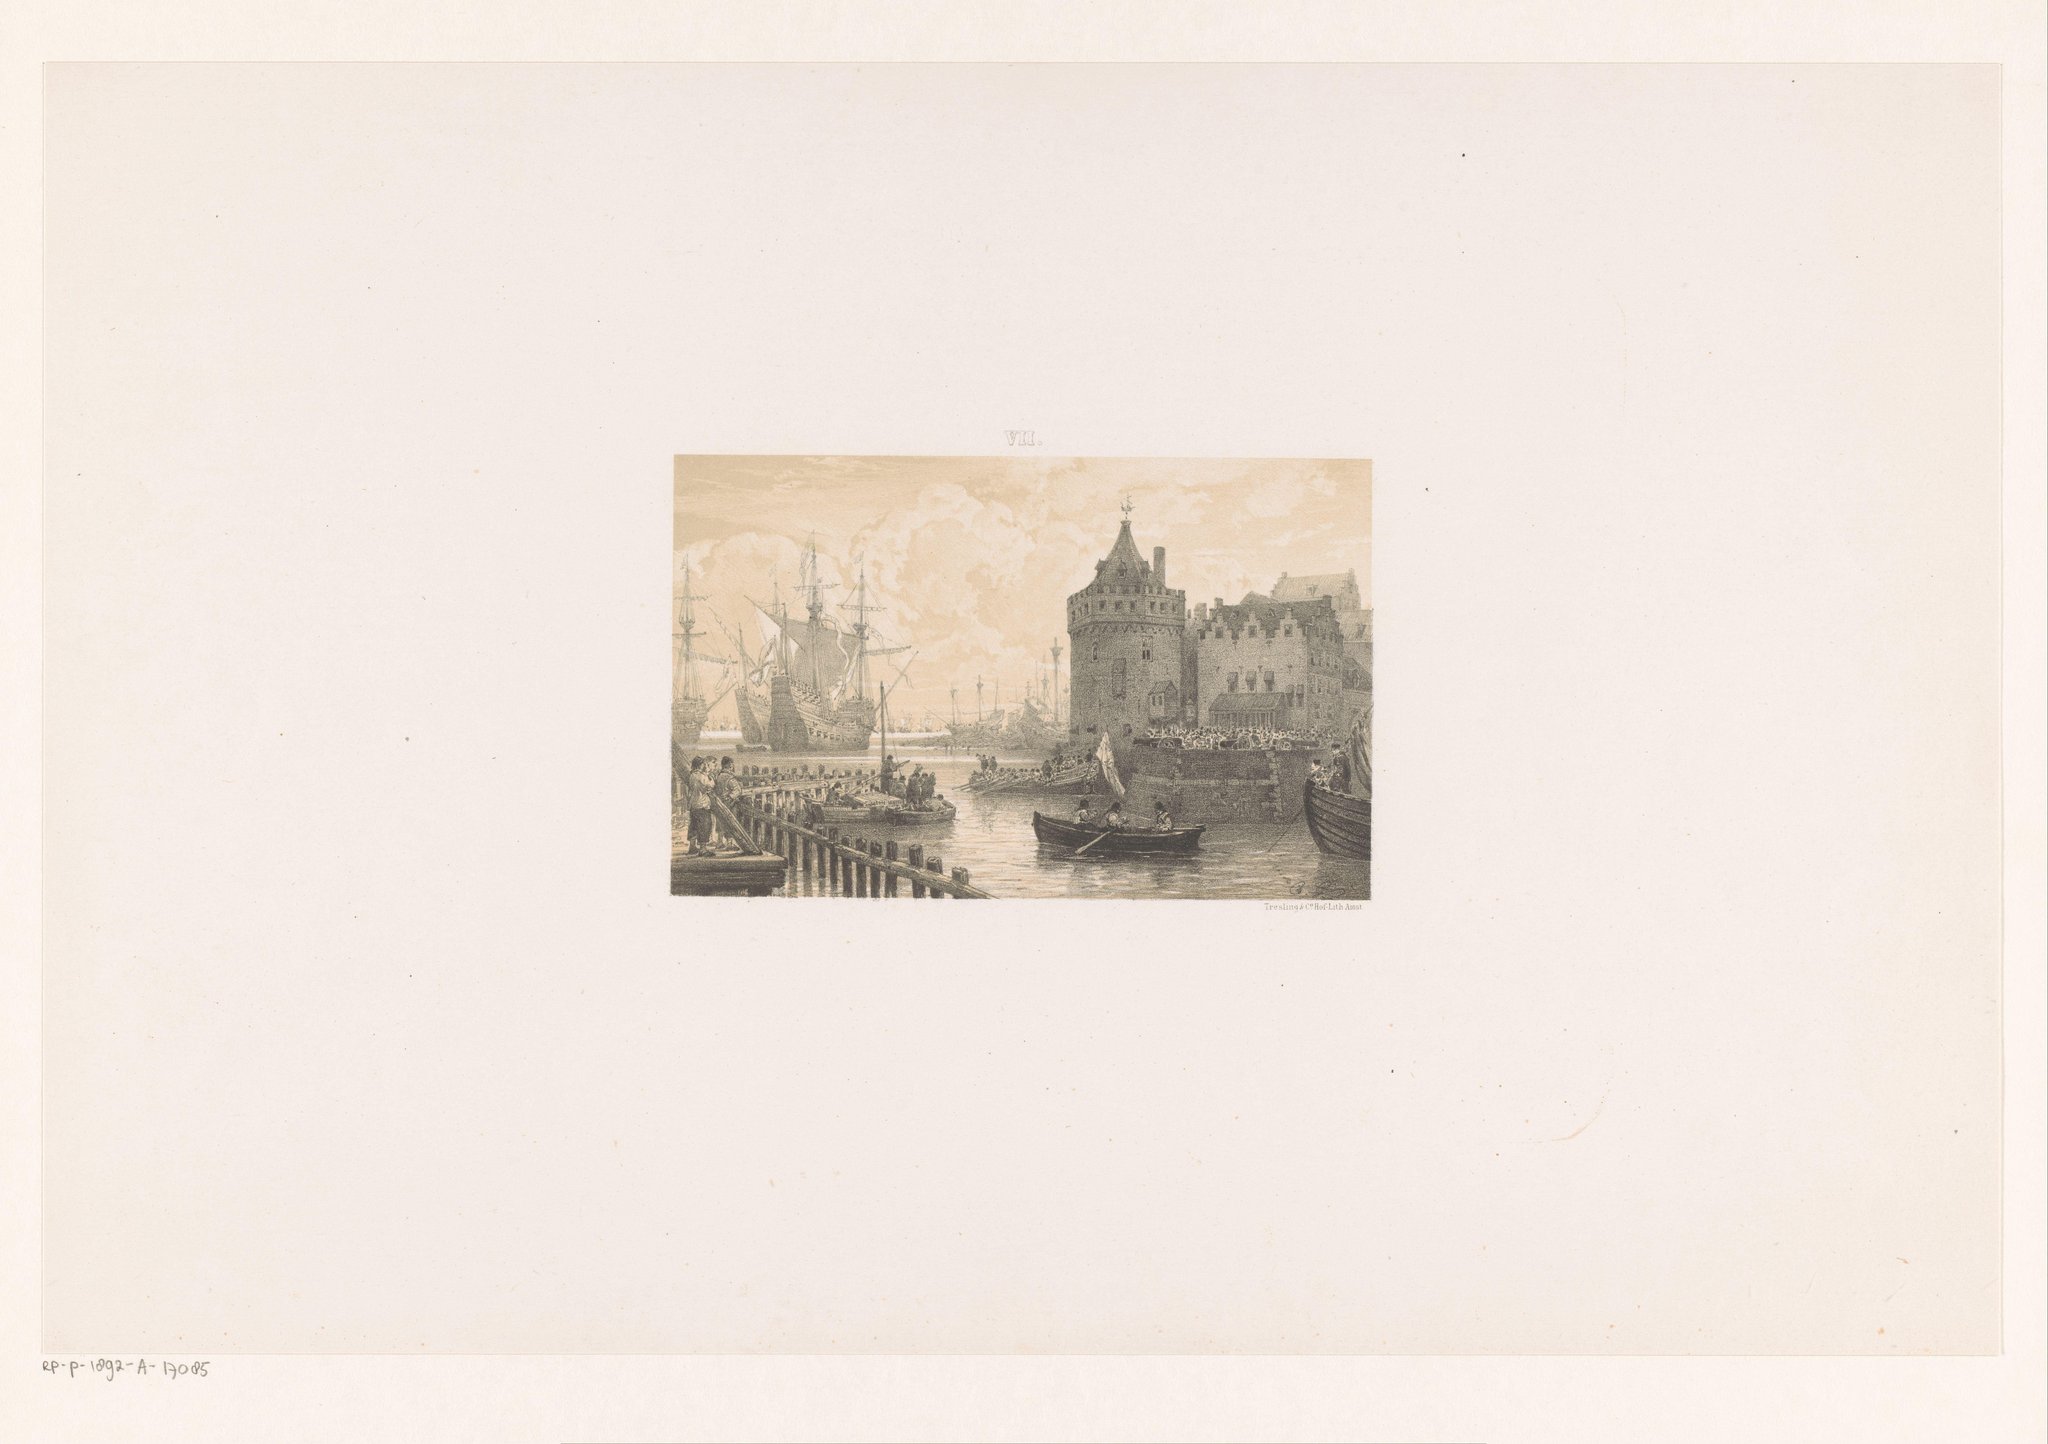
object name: print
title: Graaf van Bossu geeft zich over aan de Spaanse inquisitie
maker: johan conrad greive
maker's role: draughtsman, painter, print maker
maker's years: 1837-1891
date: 1876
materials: paper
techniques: tone lithography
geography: amsterdam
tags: harbour, sailing-ship, sailing-boat (+ preparations ~ departure), amsterdam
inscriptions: collector's mark: Lugt 2228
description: Grote zeilschepen liggen te wachten in de haven. Vanaf de kade stappen de graaf en zijn bemanning in kleinere roeiboten. Rechts de Schreierstoren.